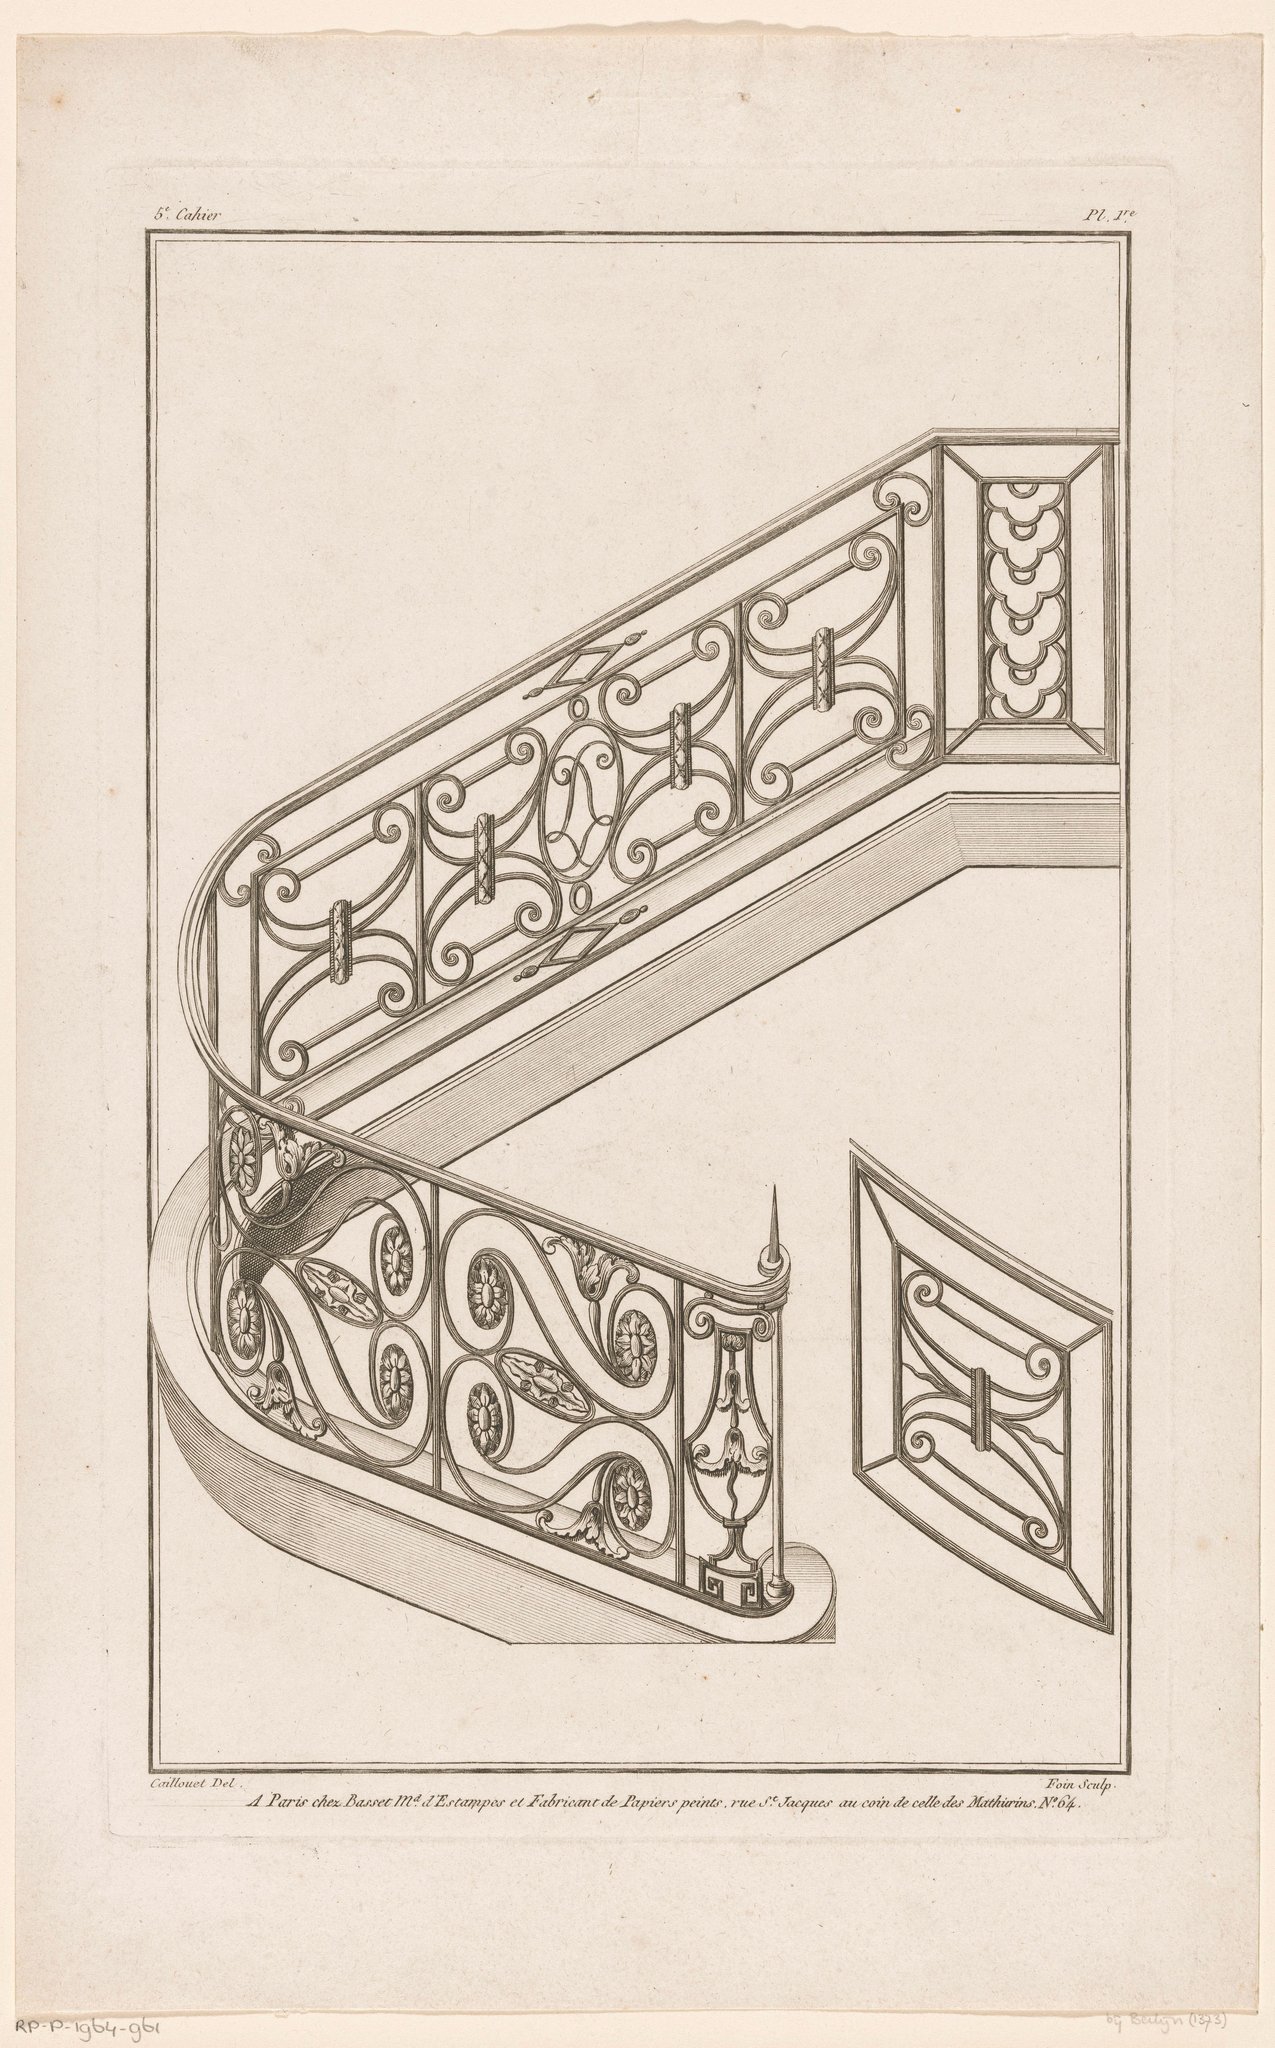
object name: print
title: Traphekken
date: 1736-1759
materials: paper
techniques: engraving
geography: paris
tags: staircase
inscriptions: collector's mark: Lugt 2228, collector's mark: Lugt 2760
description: Een smeedijzeren traphek met bloemmotieven in het onderste deel.